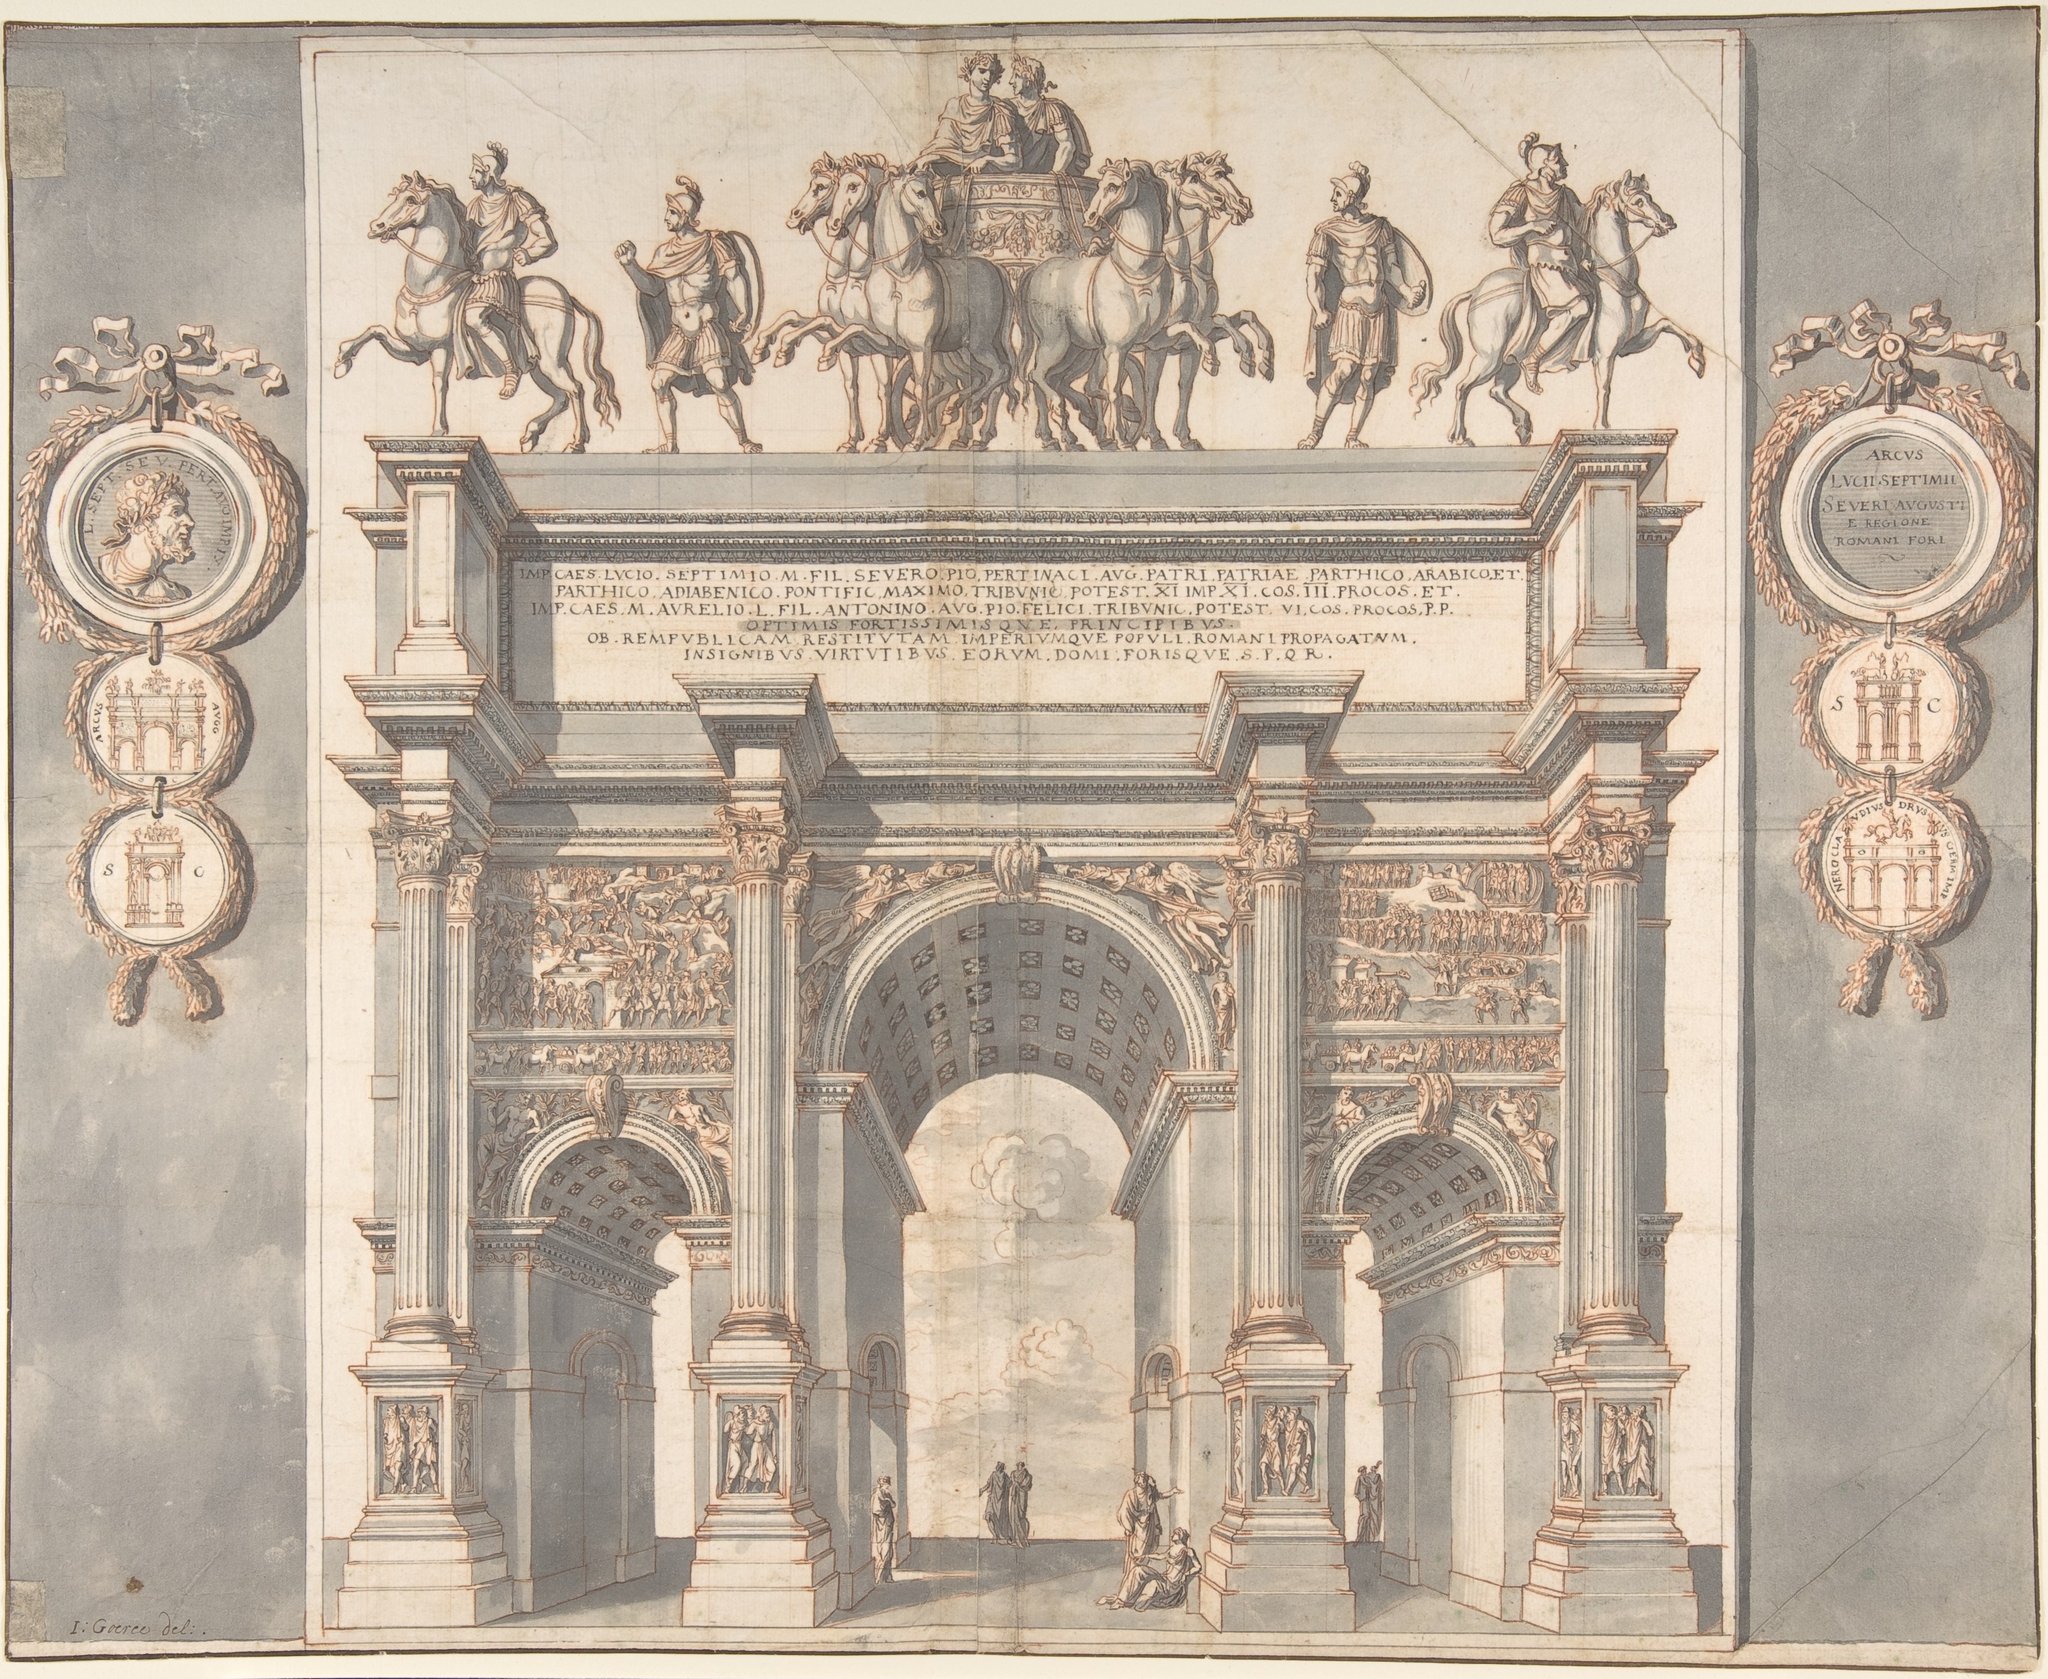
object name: drawing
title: A Reconstruction of the Arch of Septimius Severus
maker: jan goeree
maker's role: artist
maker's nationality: dutch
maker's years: 1670-1731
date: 1704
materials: chalk, ink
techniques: brush, pen, wash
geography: italy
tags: architecture,arches,men,horses